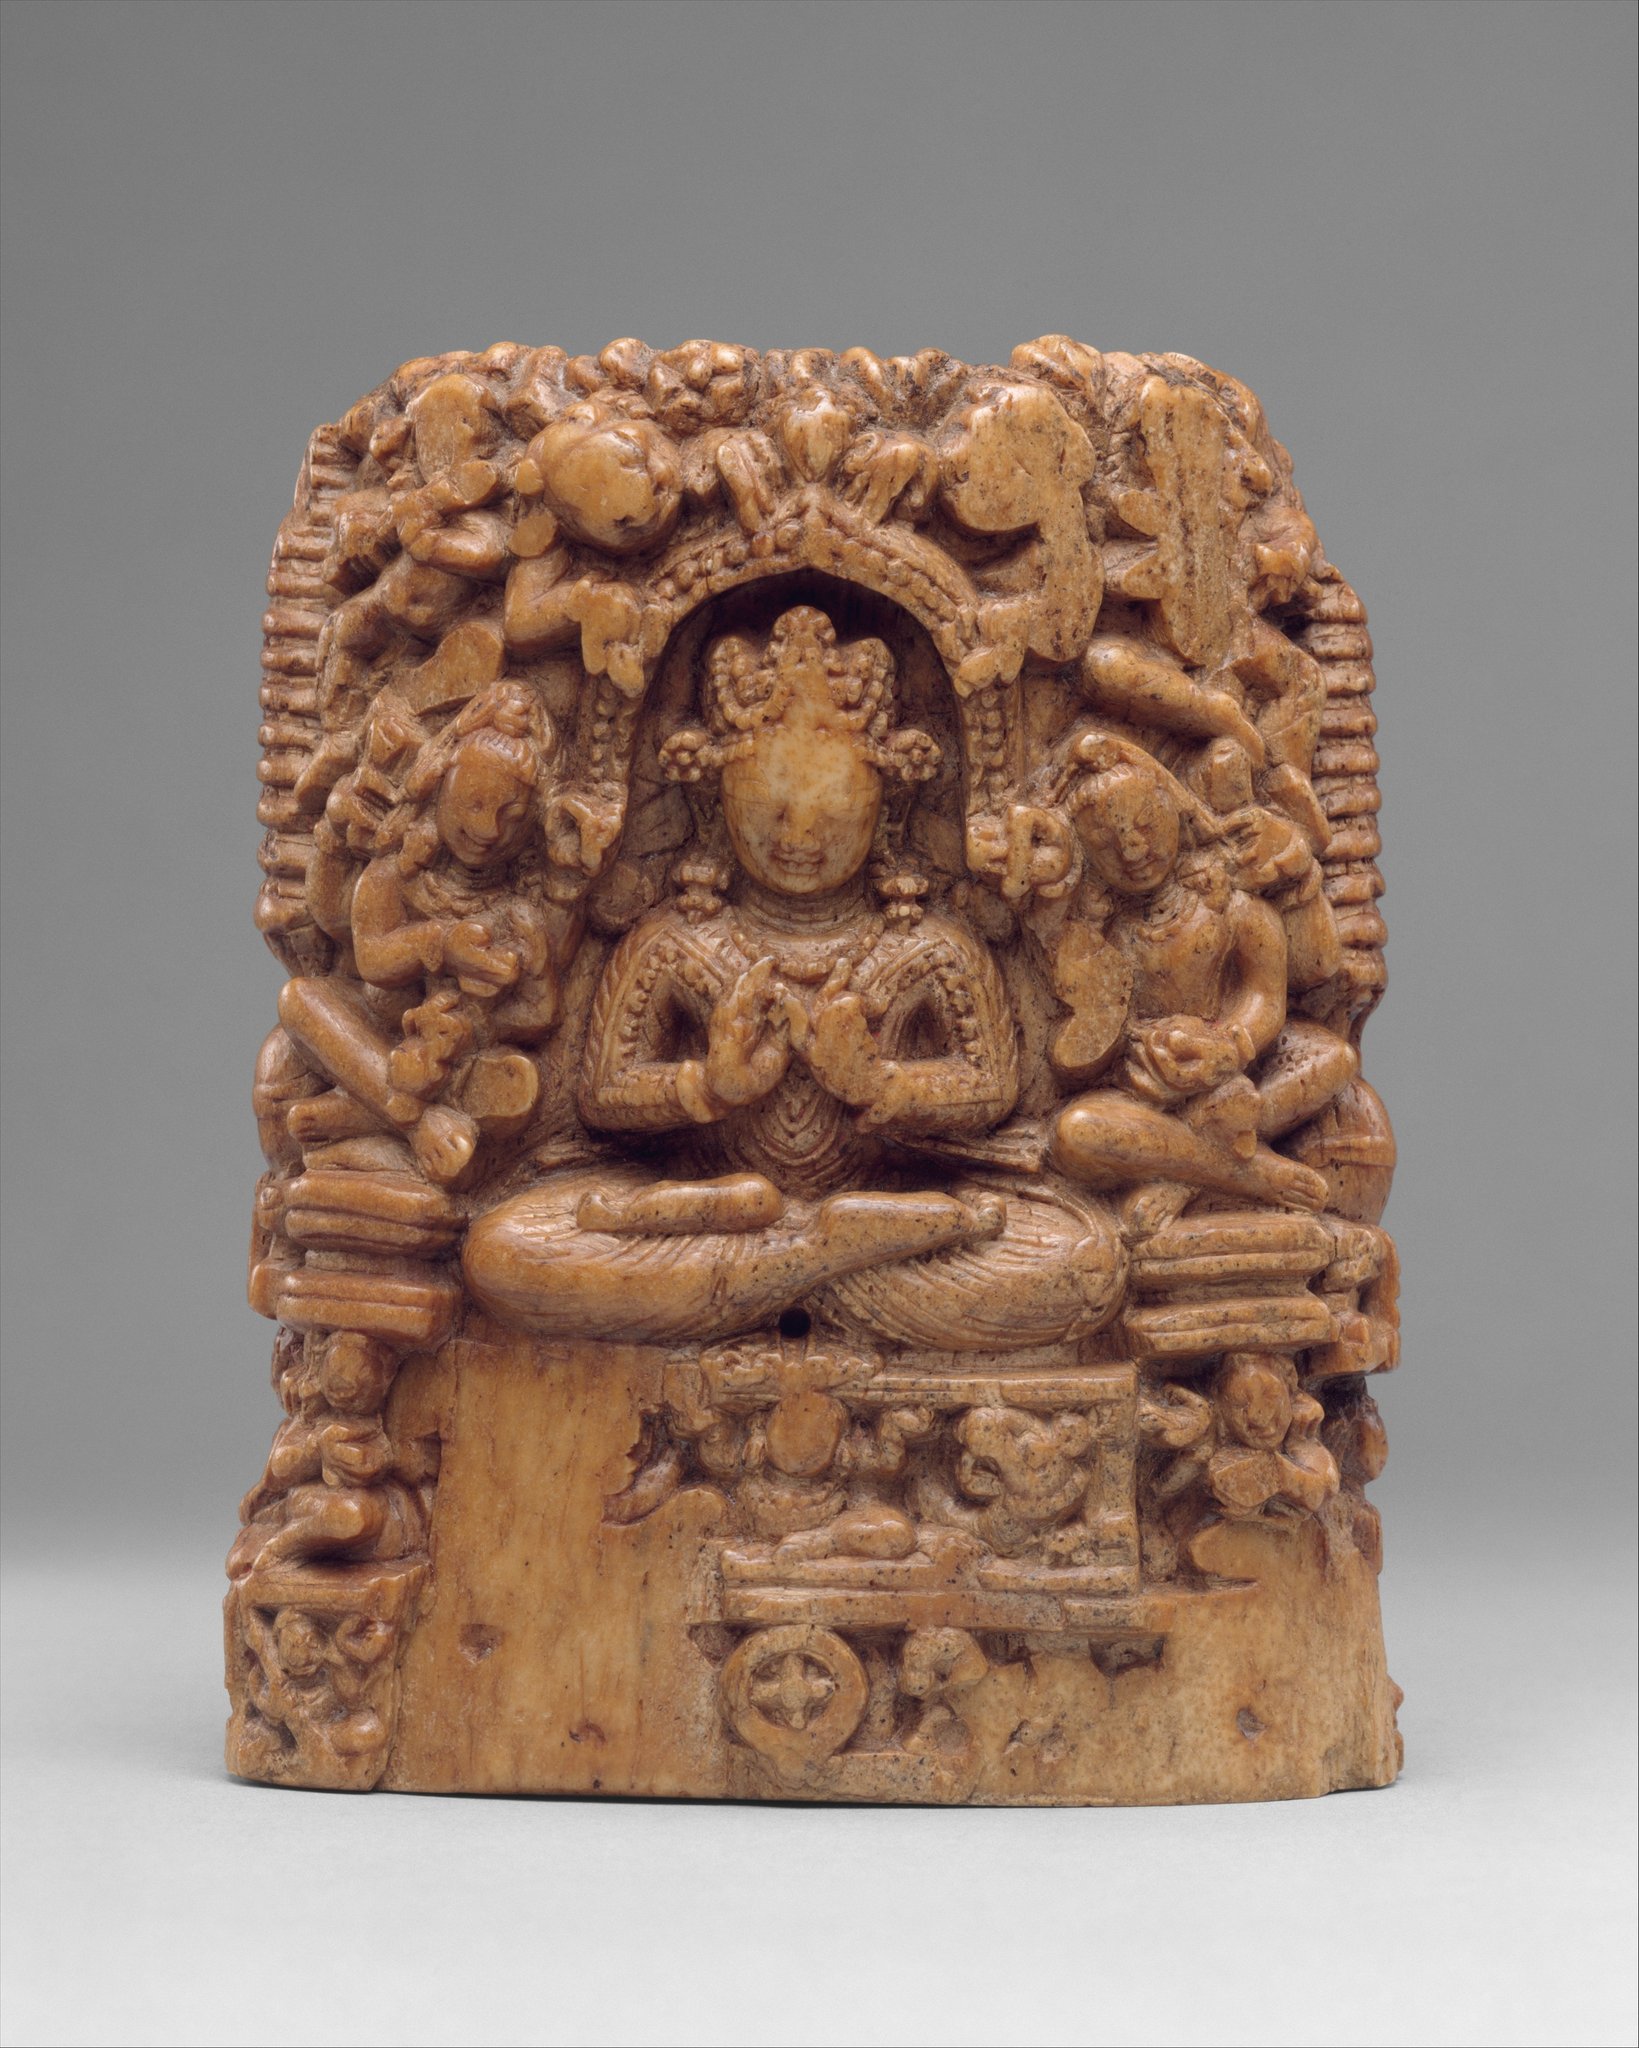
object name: reliquary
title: Reliquary(?) with Scenes from the Life of Buddha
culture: india, jammu & kashmir or pakistan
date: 901-1000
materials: bone, gold paint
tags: kashmir,buddhism,buddha